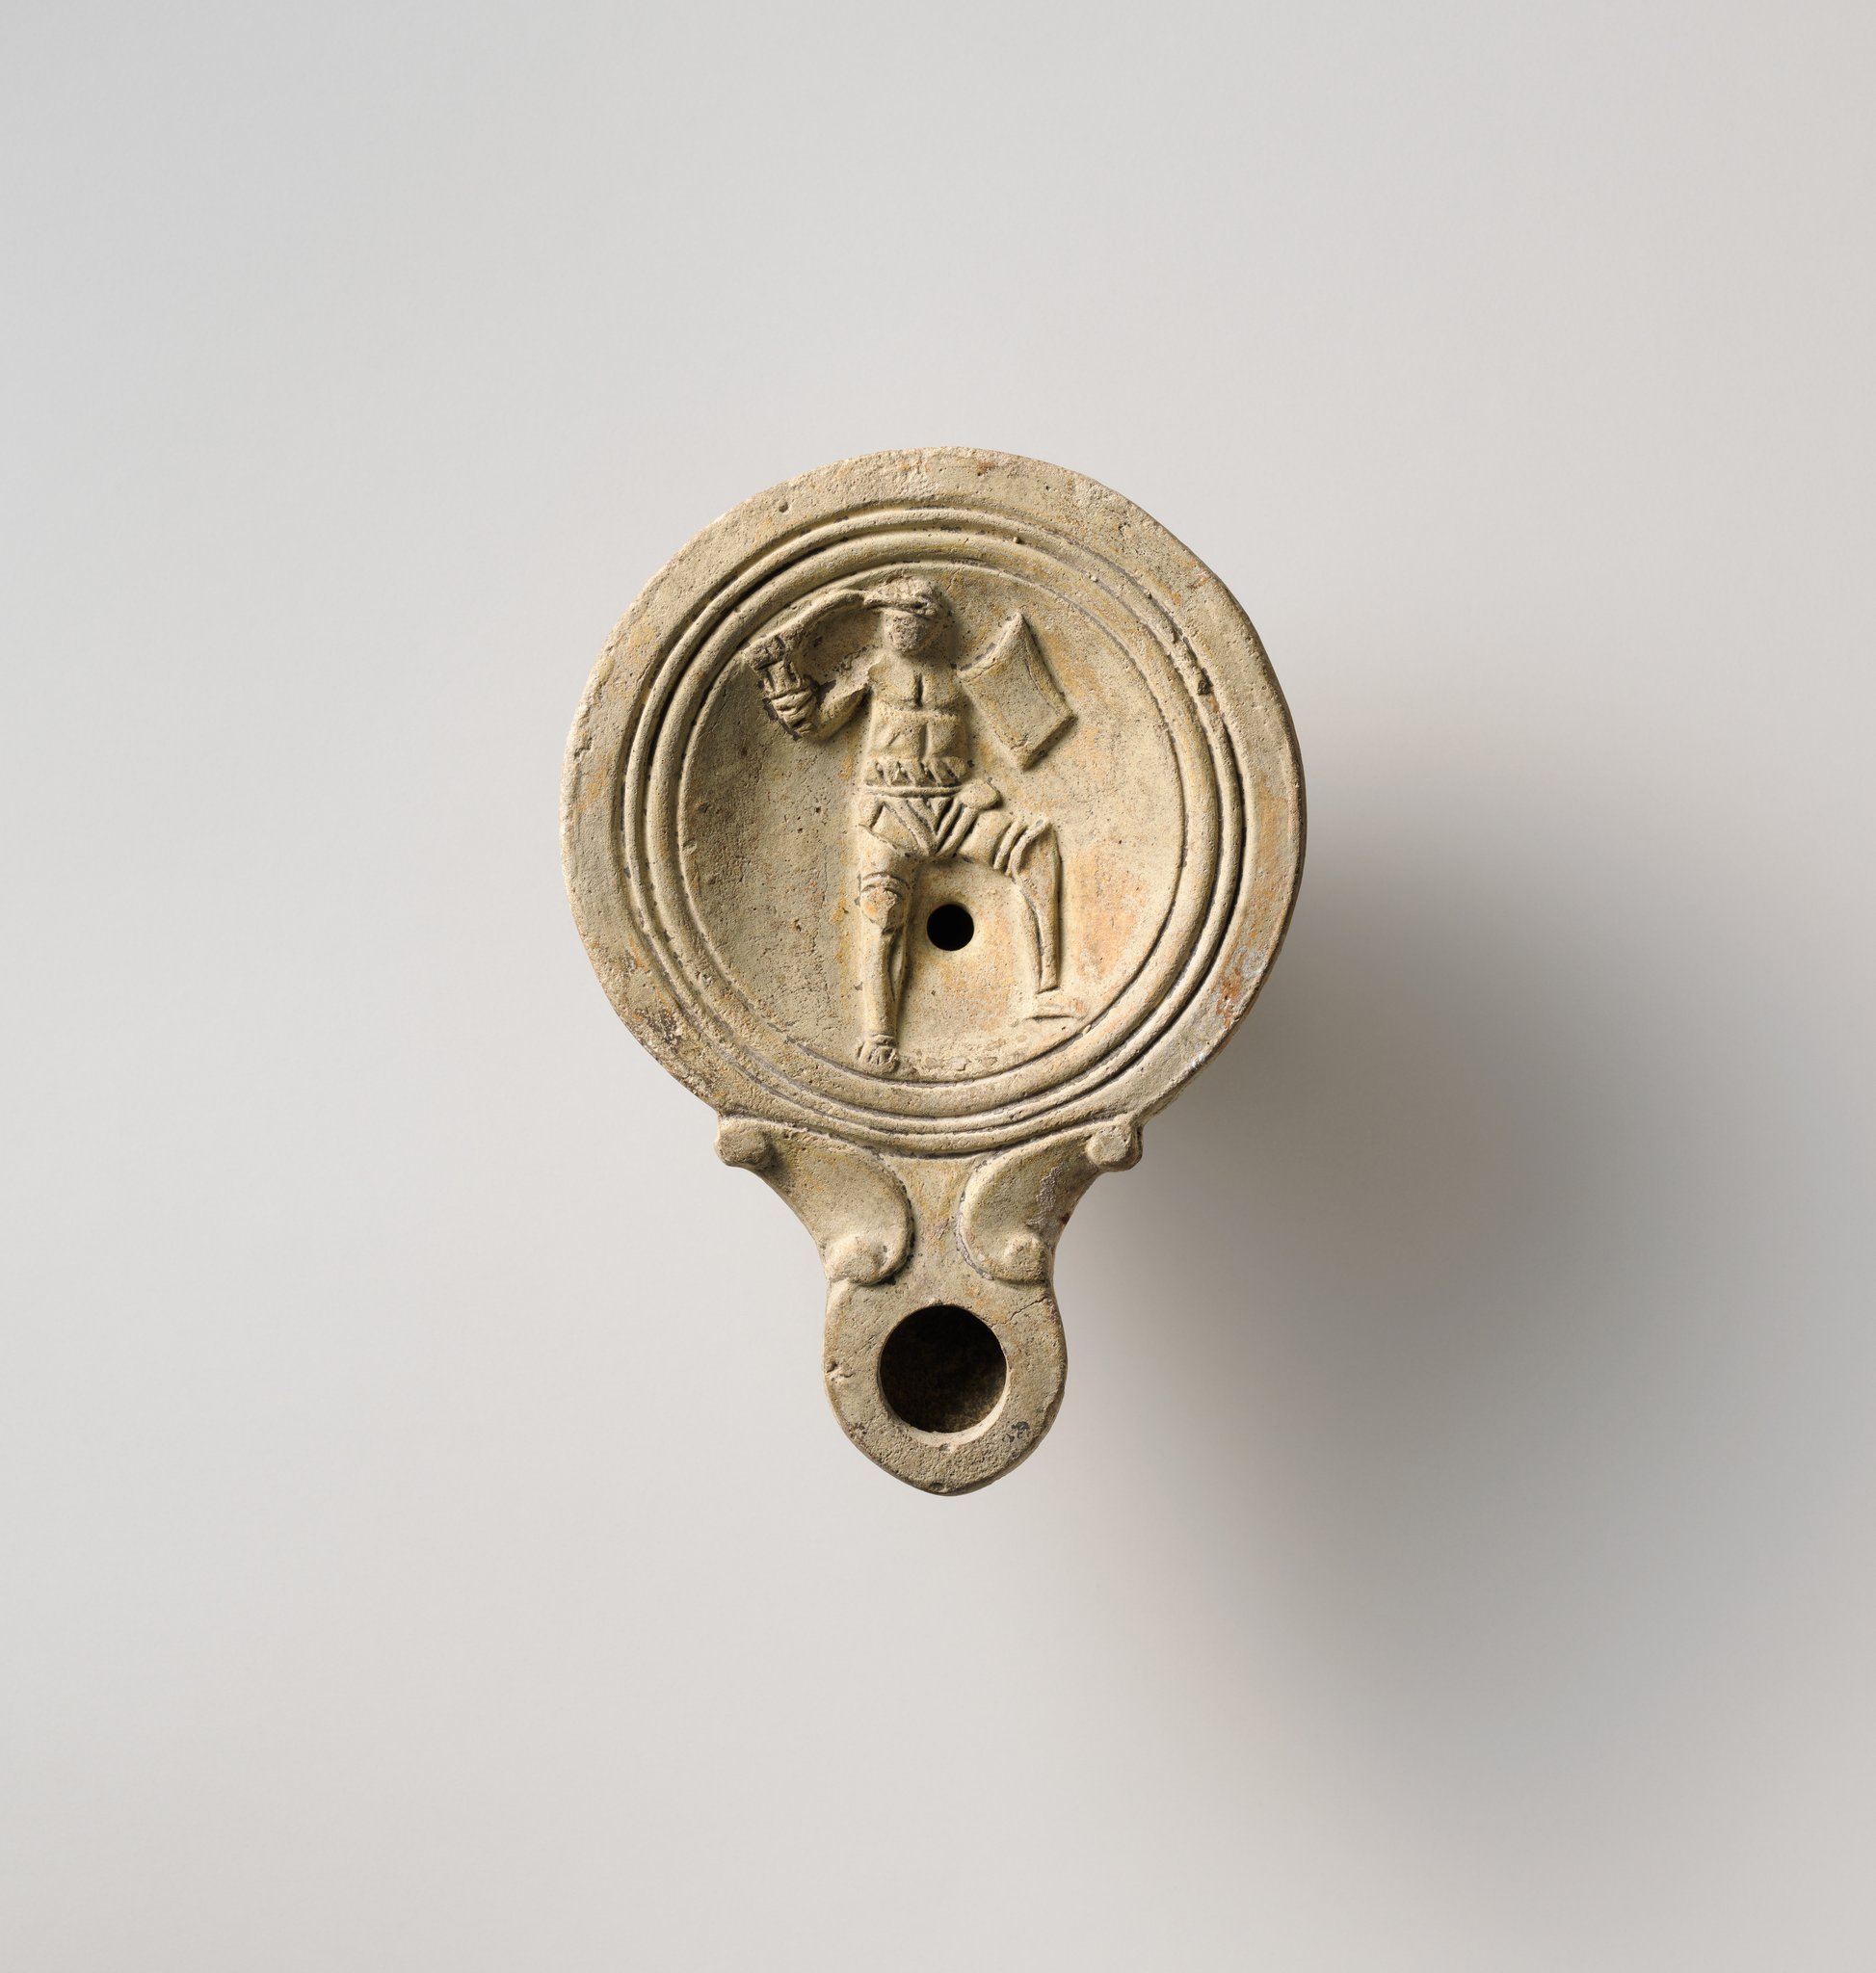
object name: lamp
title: Terracotta oil lamp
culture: roman, cypriot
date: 40-100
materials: terracotta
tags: gladiators